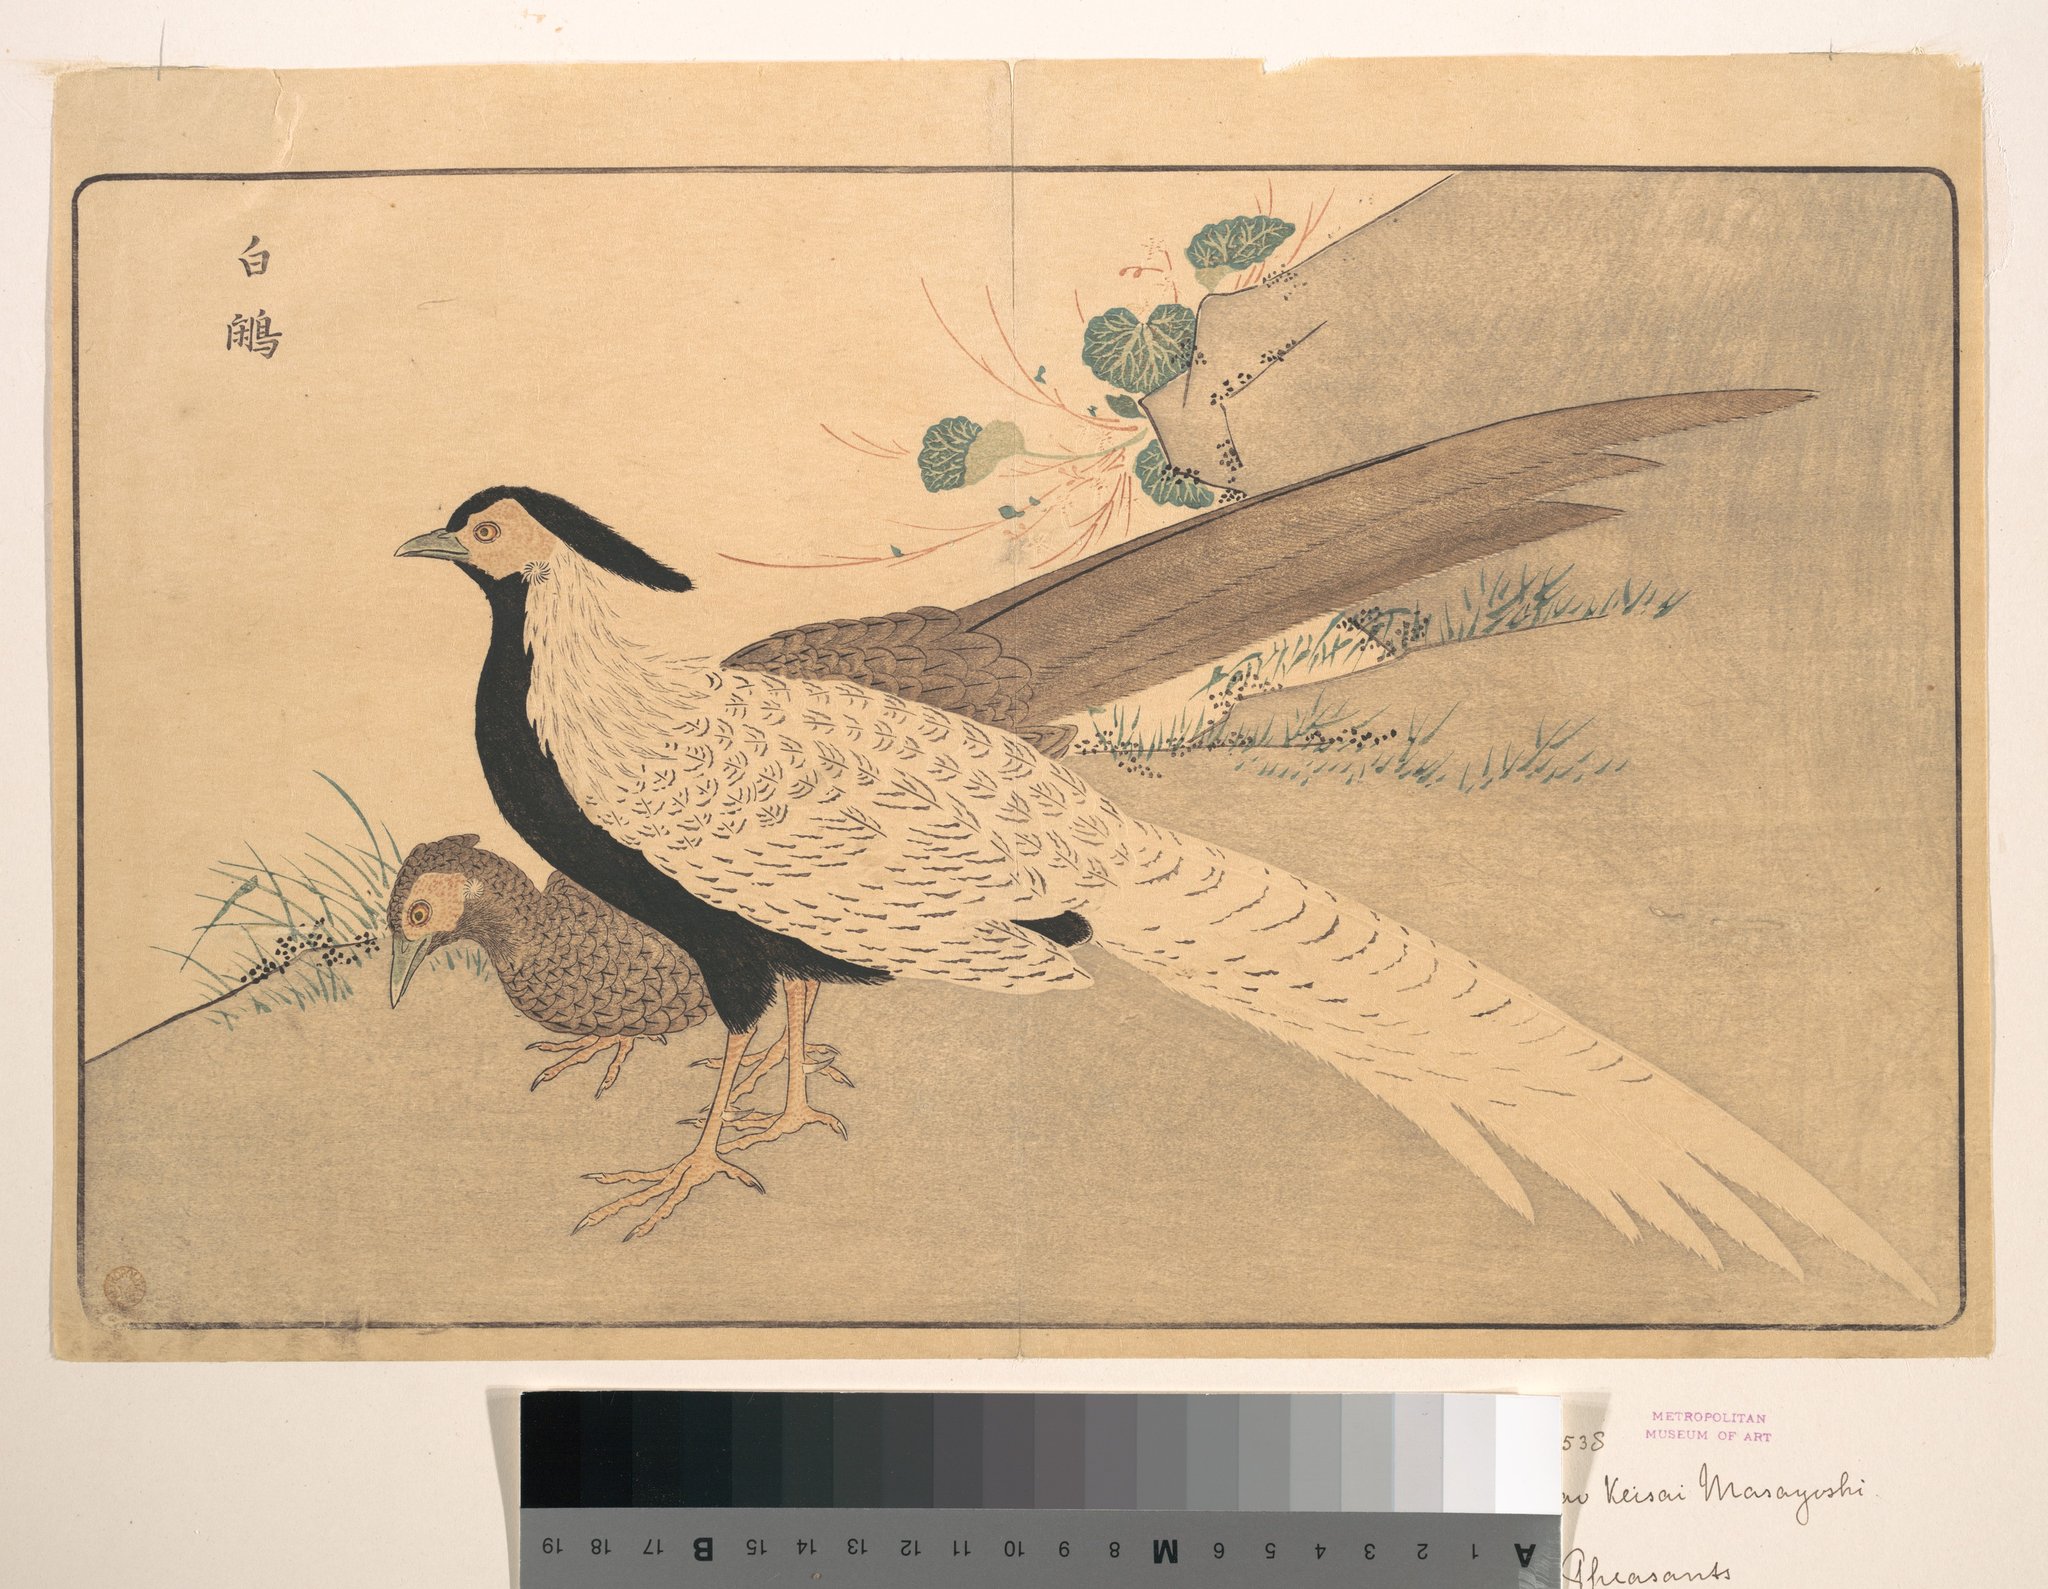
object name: print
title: Bai xian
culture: japanese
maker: kuwagata keisai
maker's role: artist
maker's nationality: japanese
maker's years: 1764-1824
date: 1789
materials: ink, paper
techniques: woodblock print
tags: birds